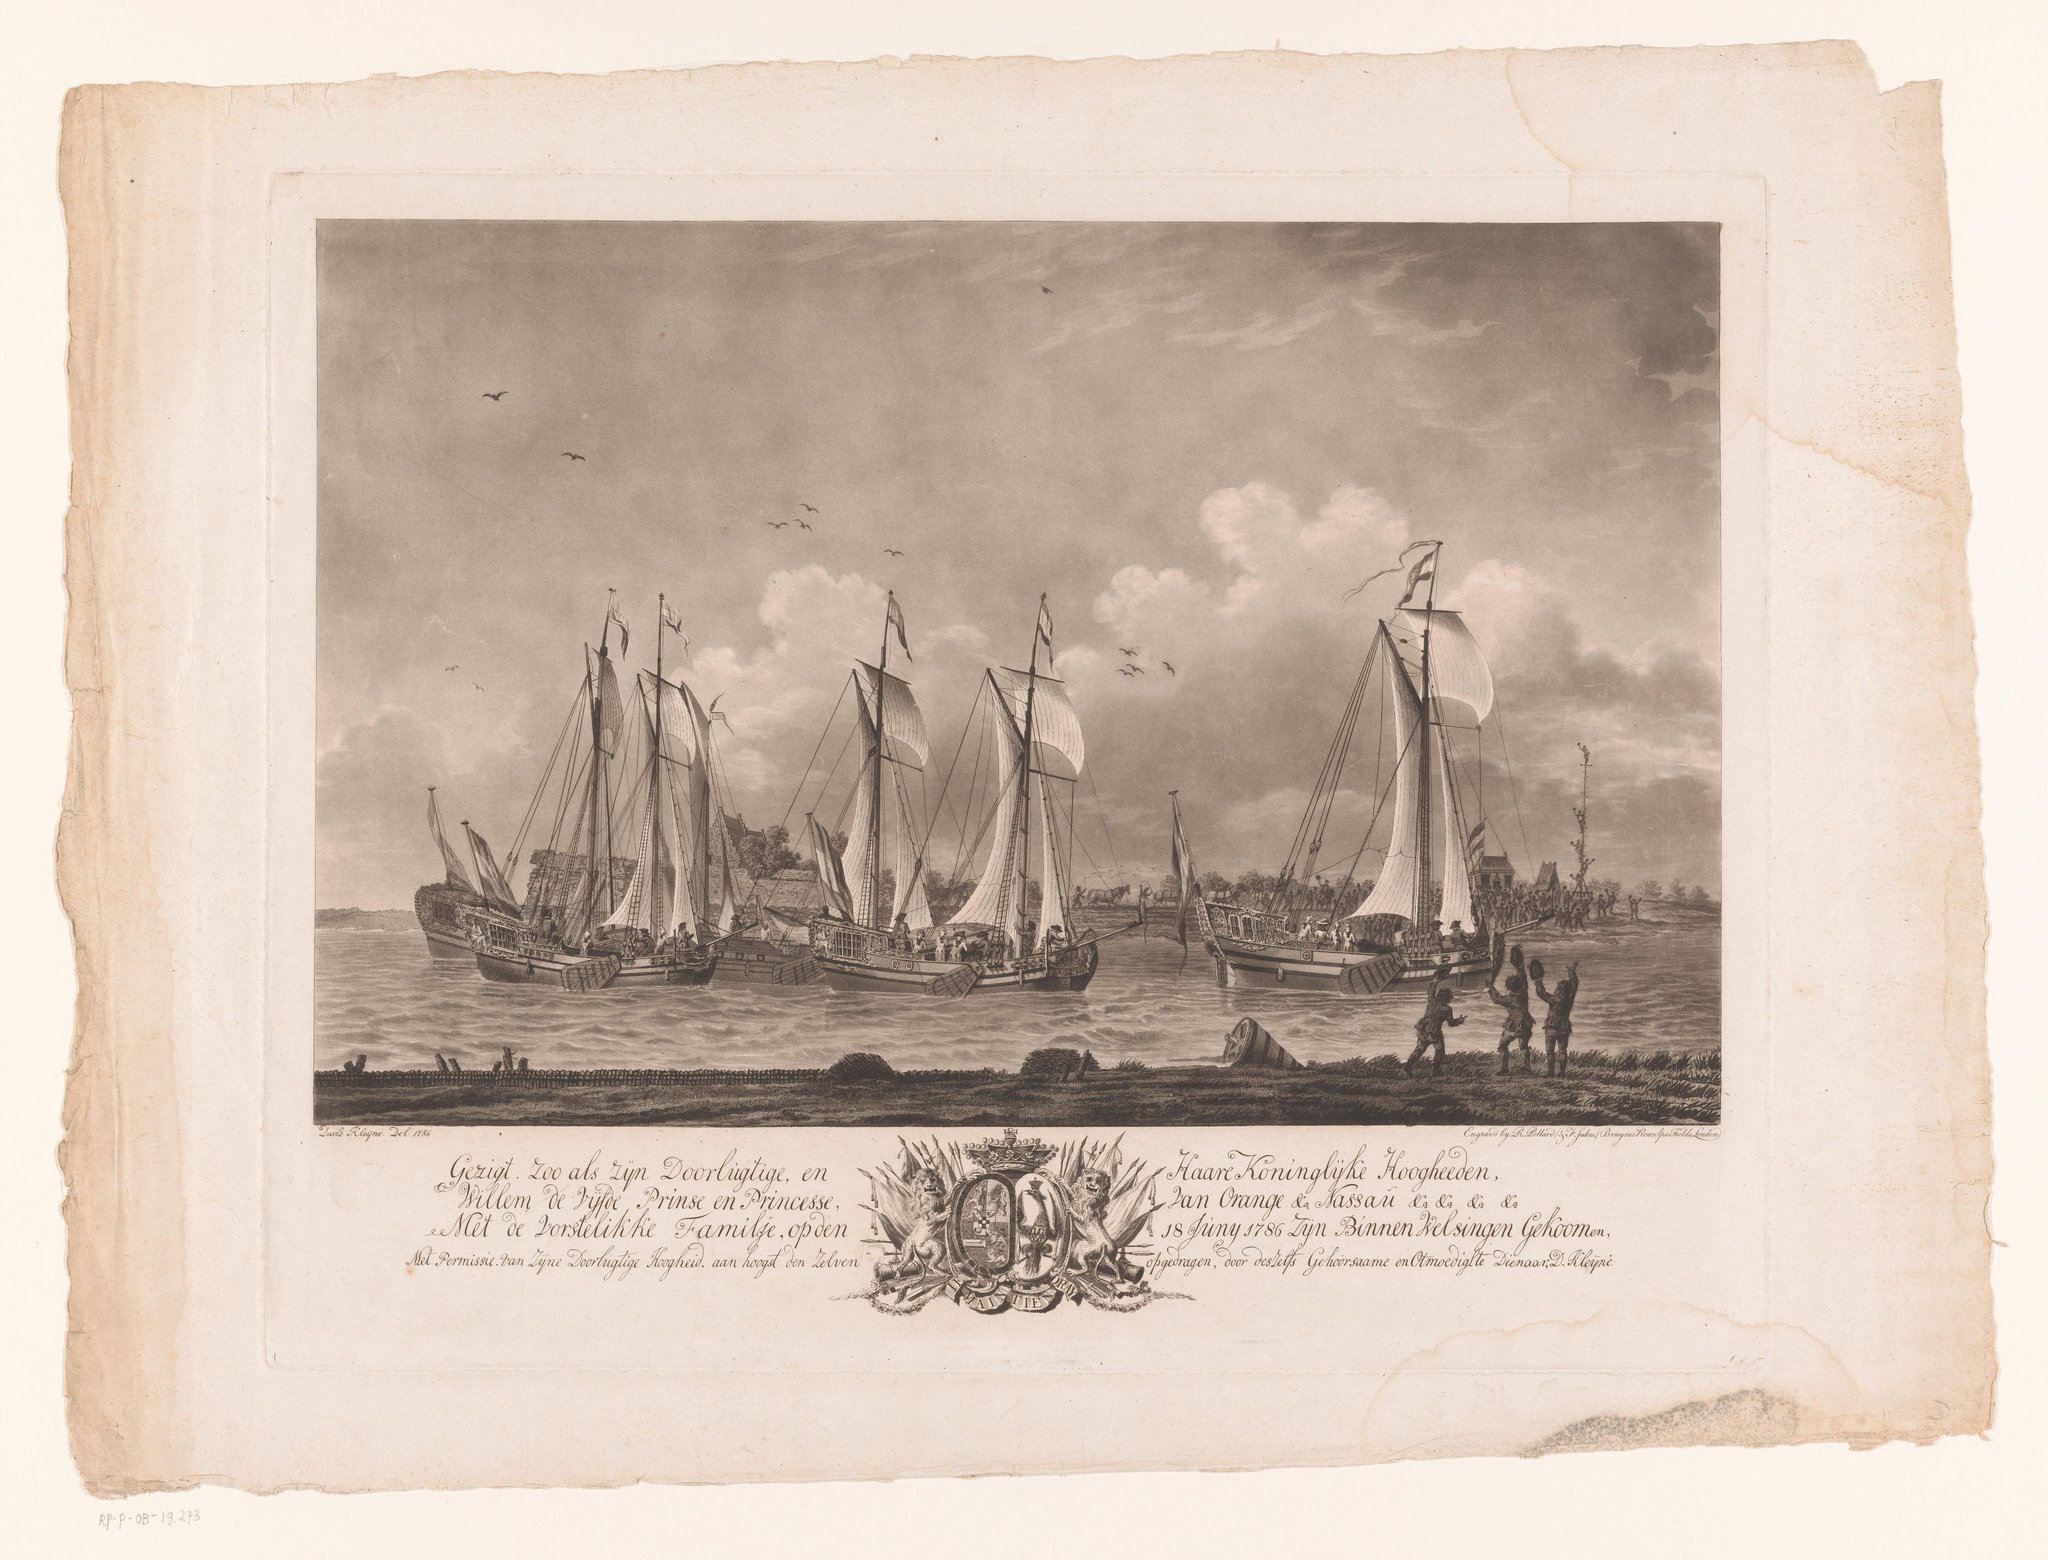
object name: print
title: Aankomst van Willem V, prins van Oranje-Nassau, en zijn familie in de haven van Welsingen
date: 1786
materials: paper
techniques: aquatint, engraving, etching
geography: london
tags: william v (prince of orange), historical persons, arrival and return ~ travelling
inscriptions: collector's mark: Lugt 2228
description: De heerlijkheid van Welsingen (het dorp) lag na meerdere dijkdoorbraken uiteindelijk buitendijks en verdween. Tegenwoordig na hernieuwde indijking is dit een deel van industriegebied Vlissingen-Oost.